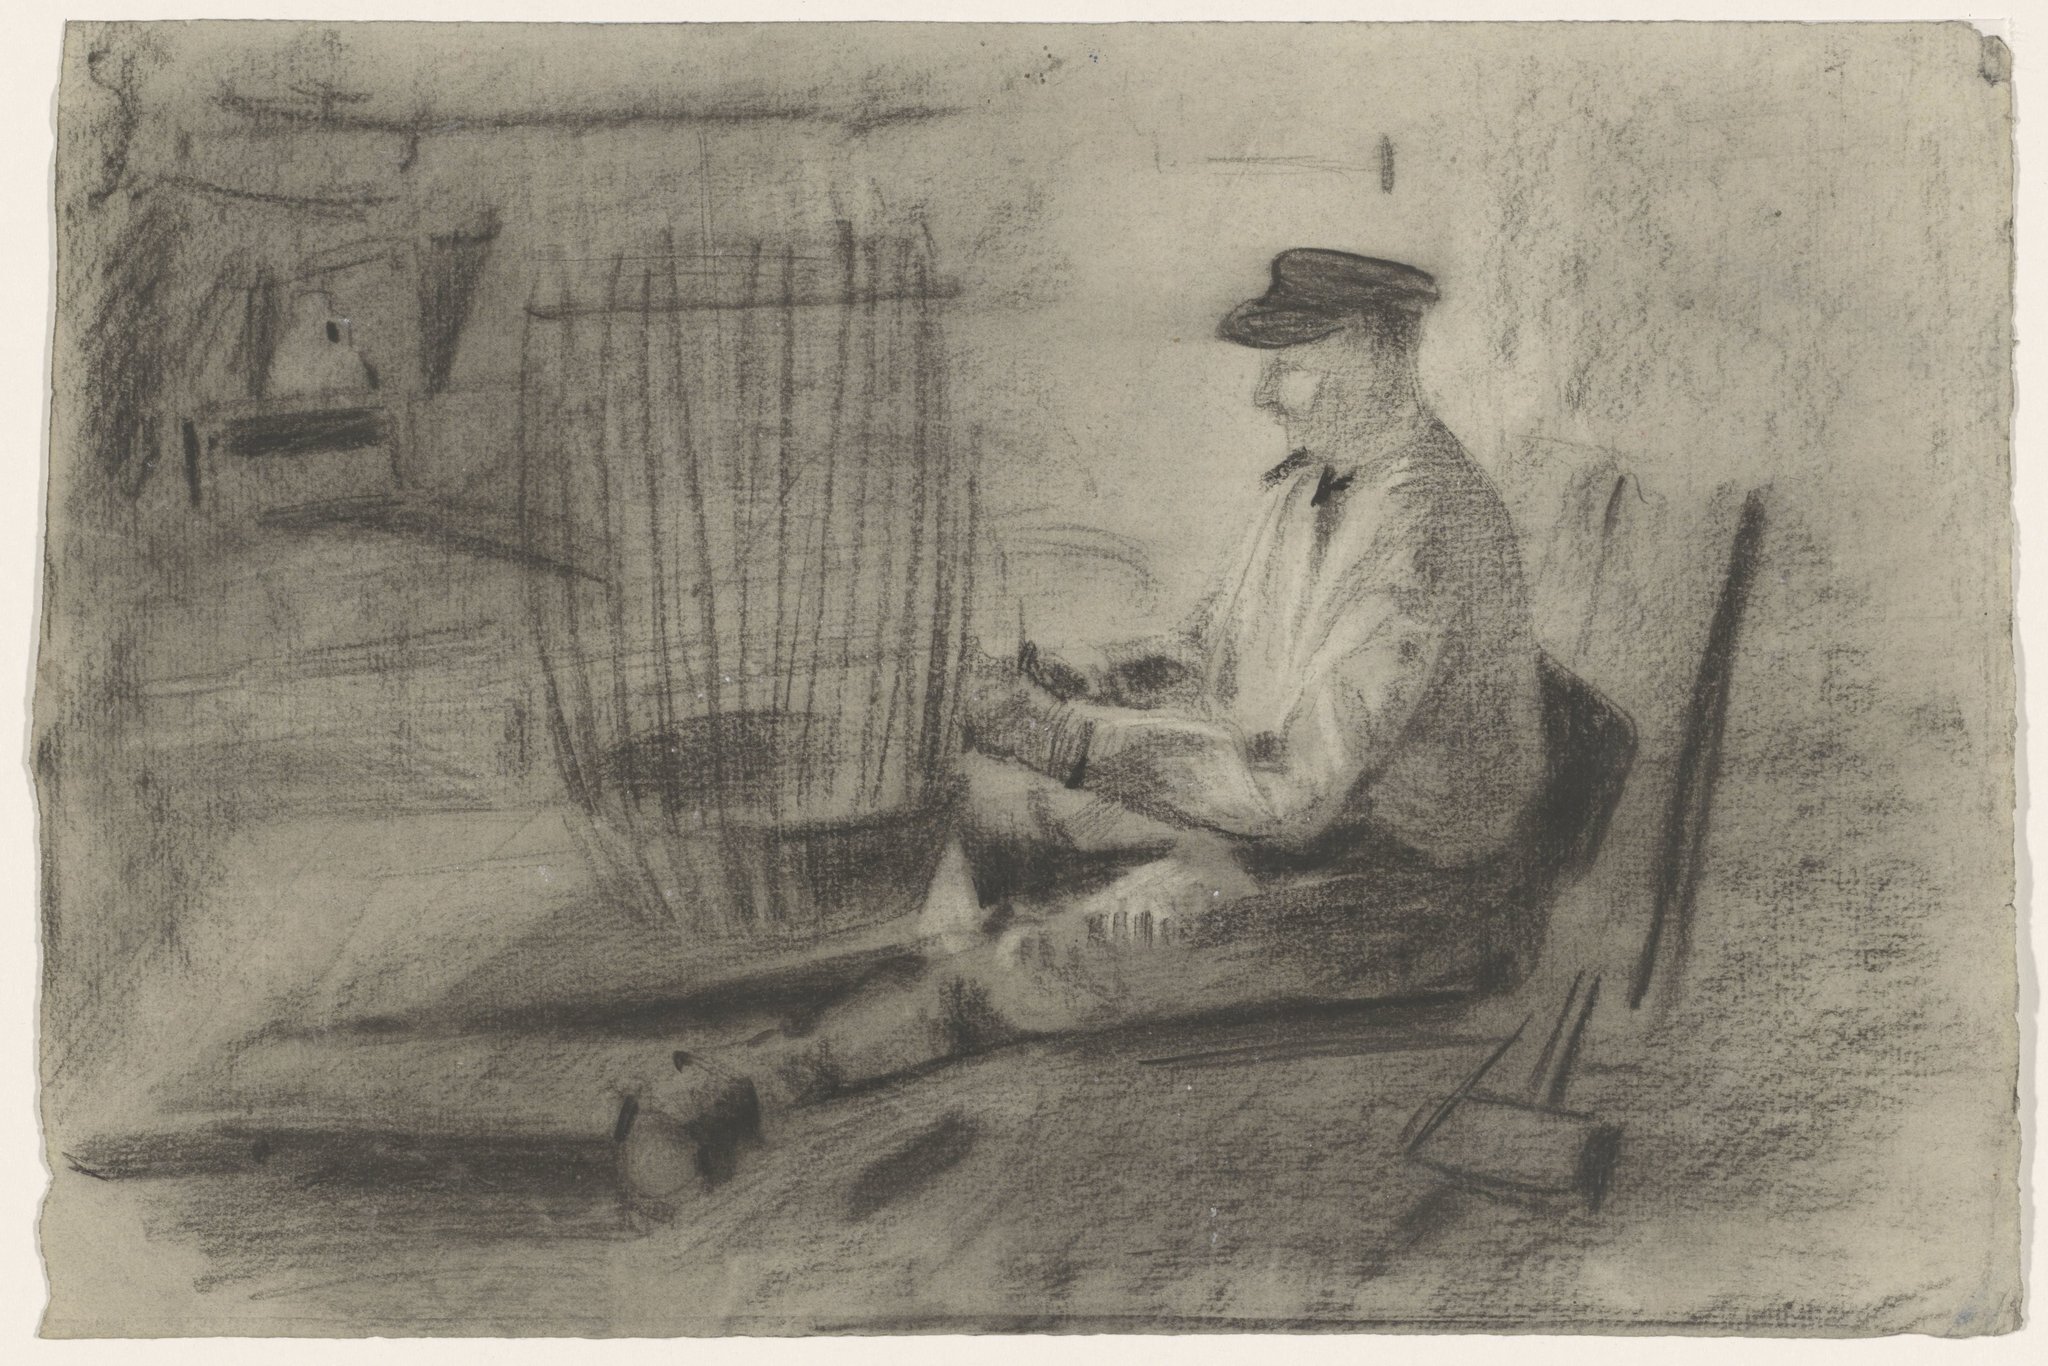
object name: drawing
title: Mandenmaker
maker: carel adolph lion cachet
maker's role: draughtsman, print maker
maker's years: 1864-1945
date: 1874-1945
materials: charcoal, paper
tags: handicrafts ~ other plant material, container made of plant material other than wood: basket